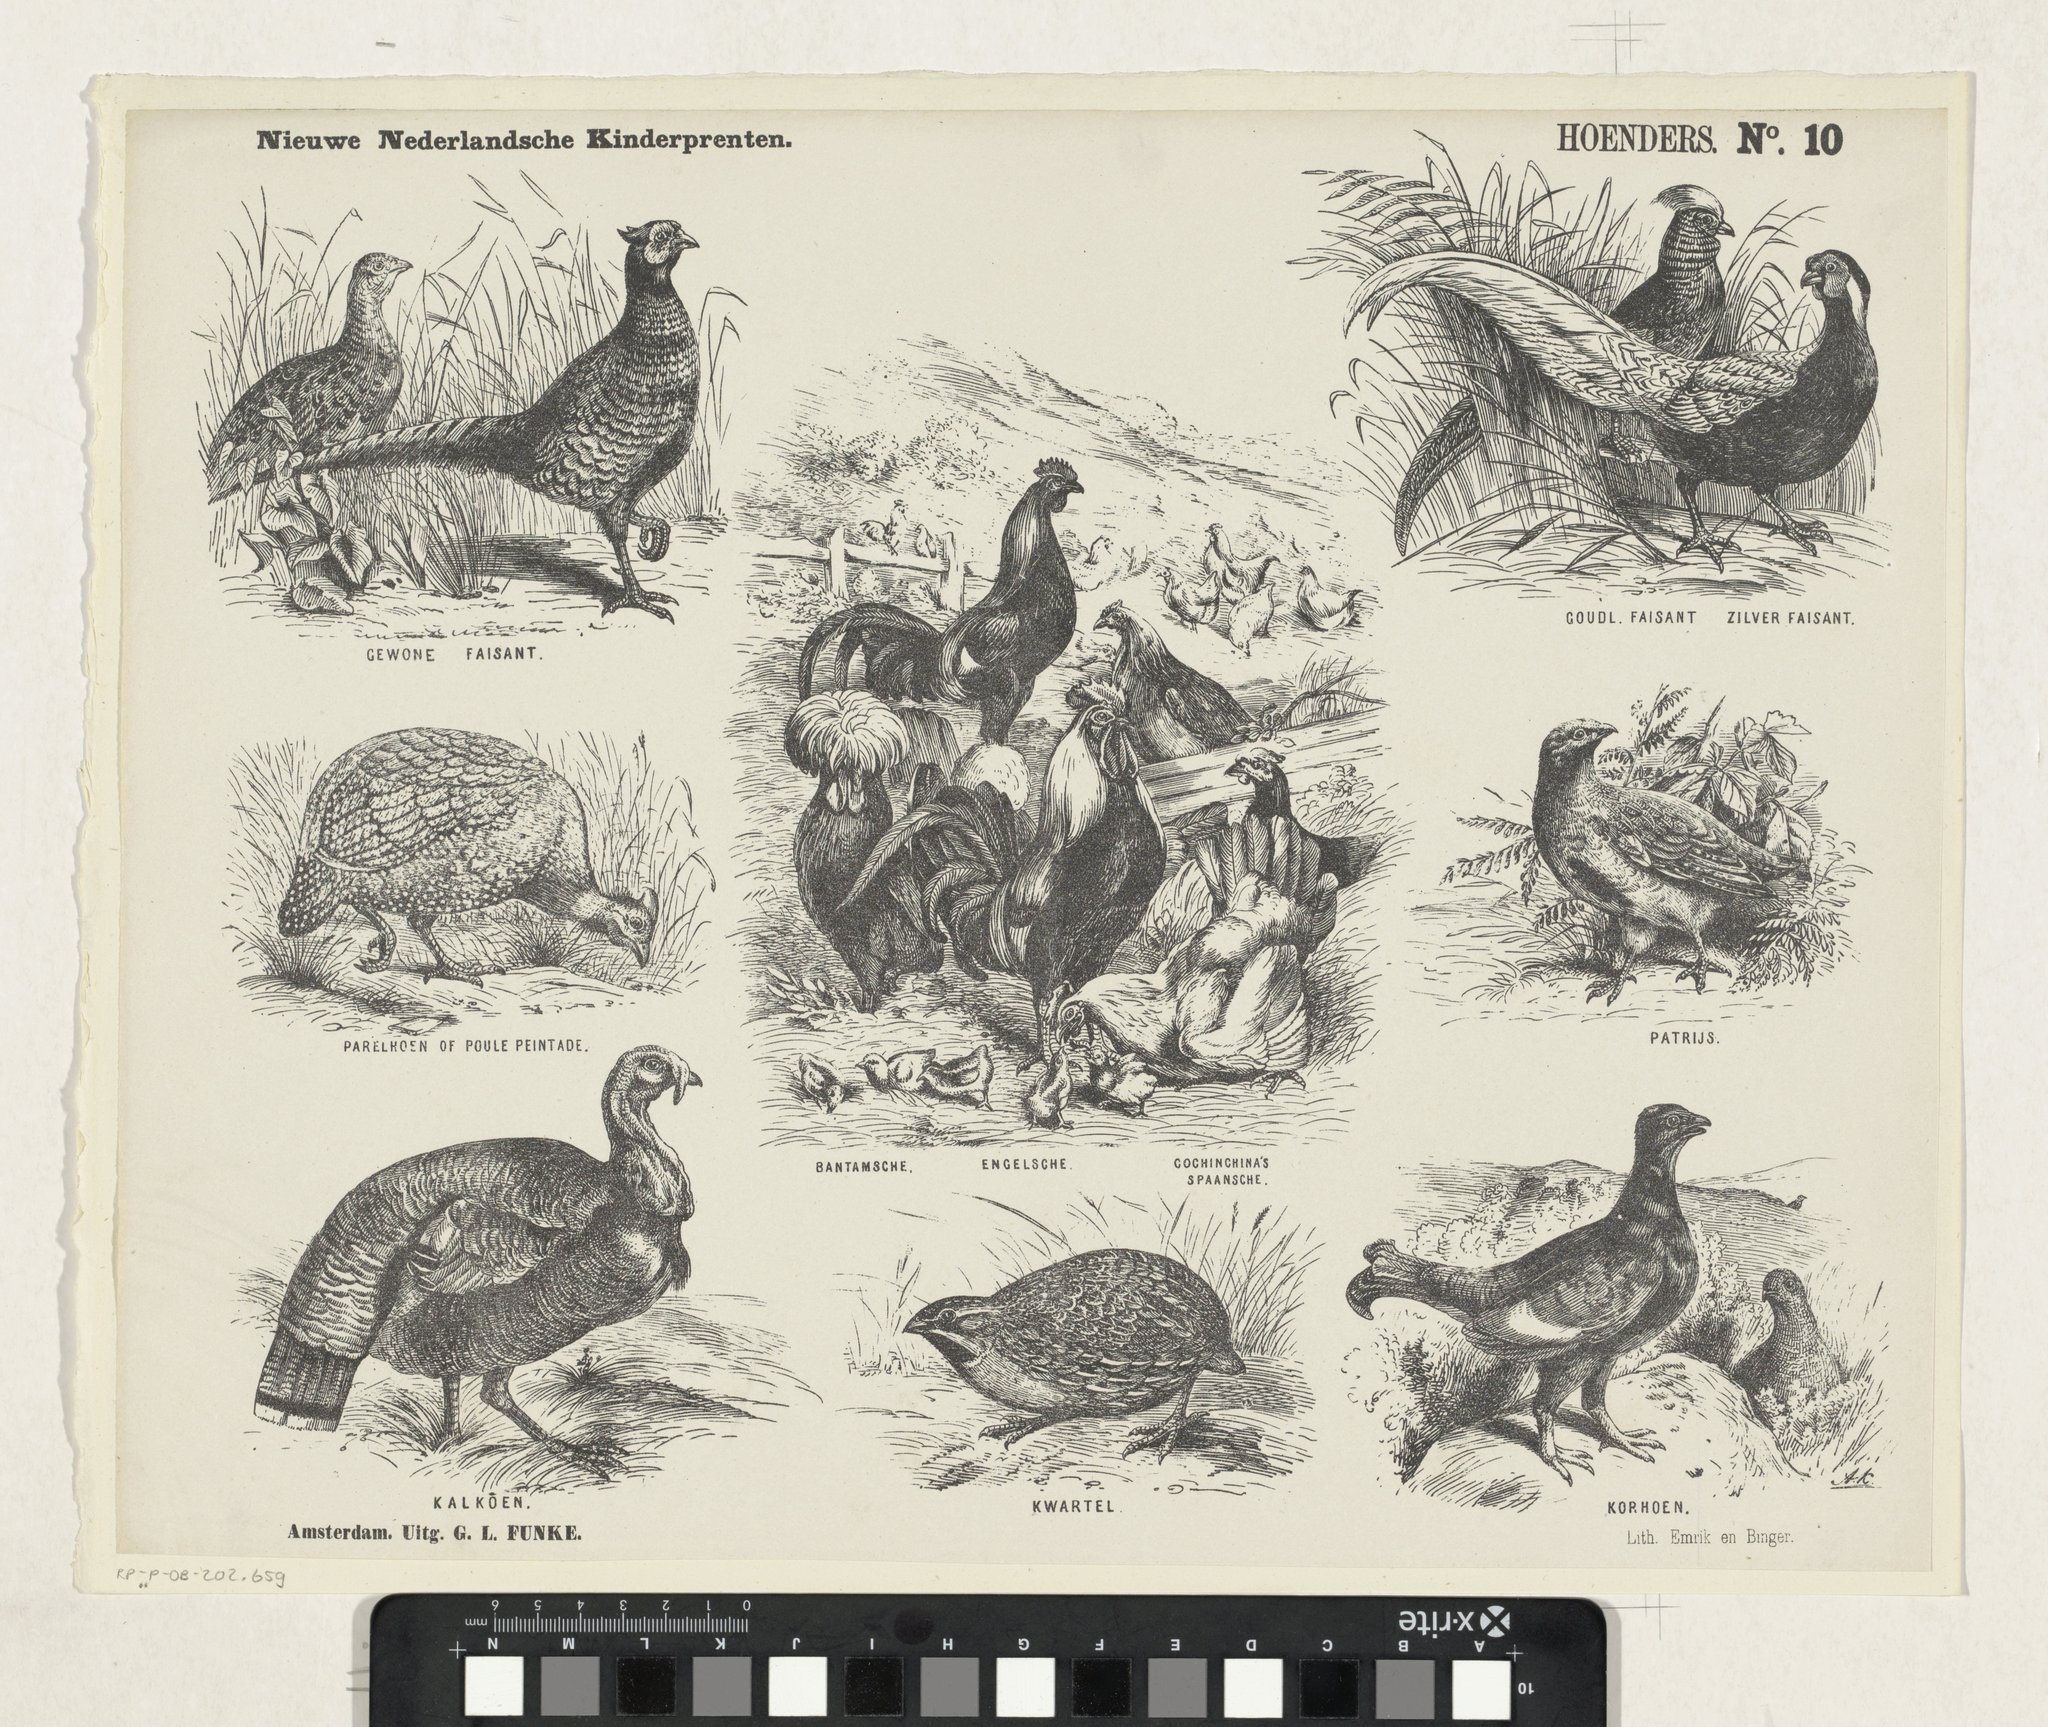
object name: print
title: Hoenders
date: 1865-1875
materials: paper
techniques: letterpress printing, lithograph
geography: amsterdam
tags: walker and runner birds, walker and runner birds: pheasant, fowl (cock, hen, chicken, etc.), walker and runner birds: turkey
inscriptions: collector's mark: Lugt 2760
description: Blad met 8 voorstellingen van hoendervogels, onder andere een fazant, een kalkoen en een kwartel. Onder elke afbeelding een onderschrift. Genummerd rechtsboven: No. 10.